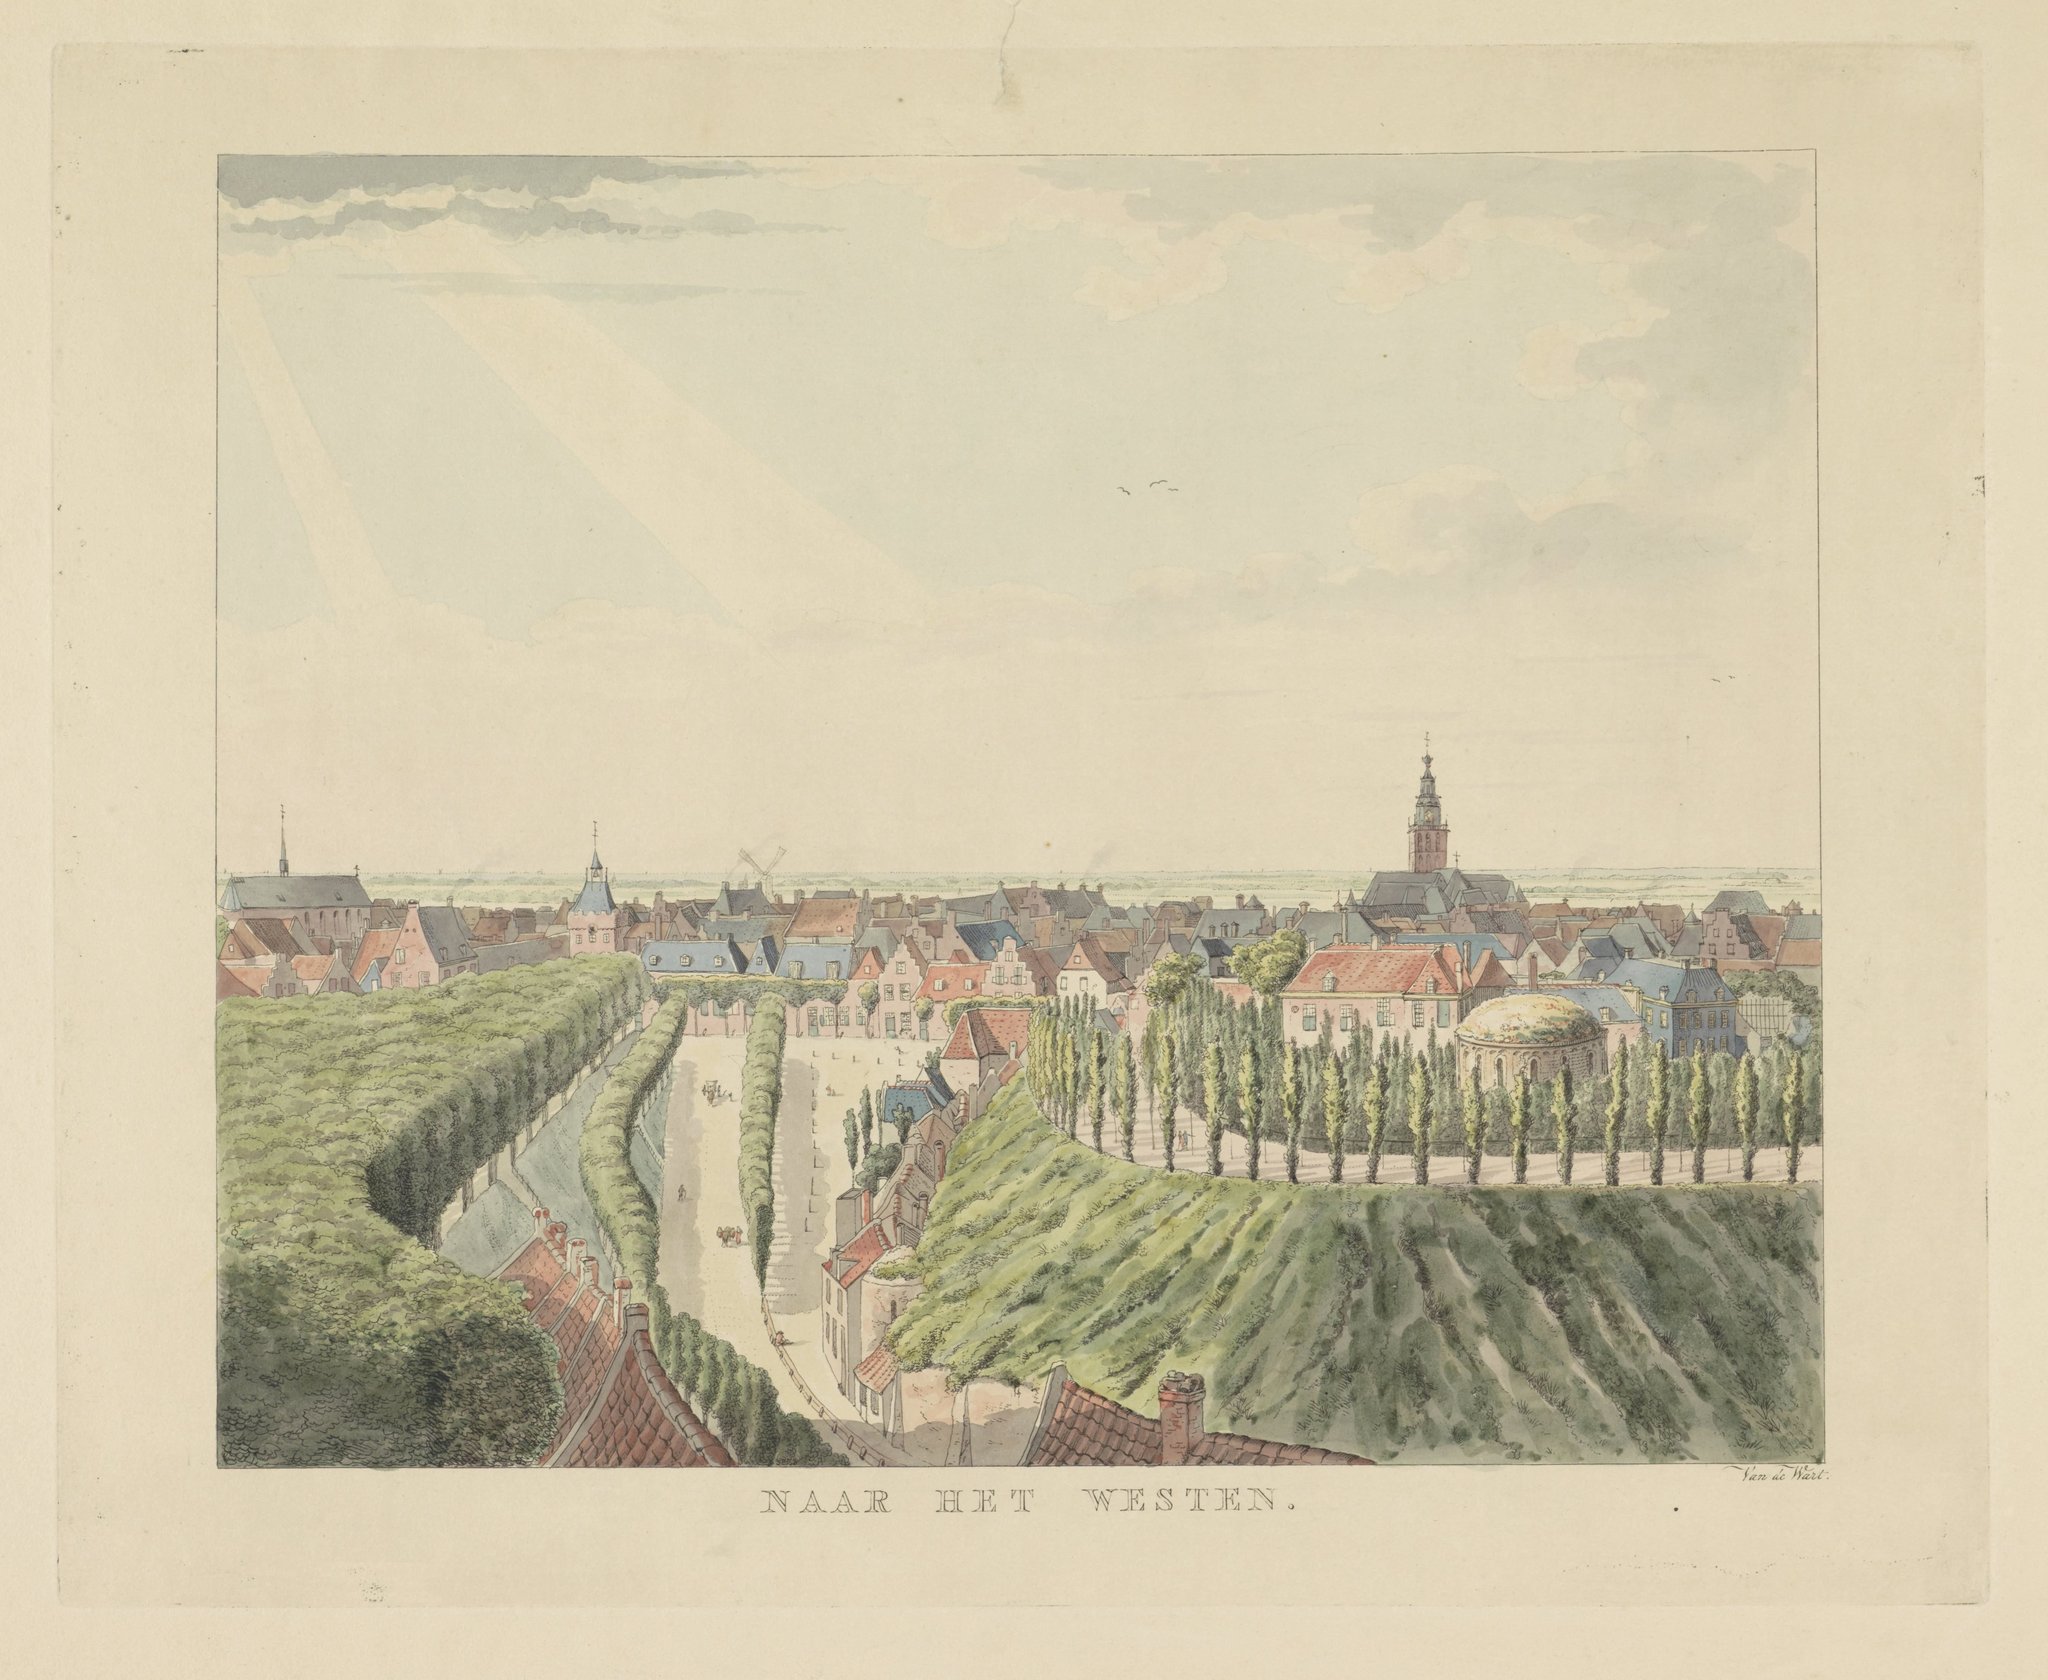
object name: print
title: Geldersch panorama of rondgezicht naar het leven geteekend op belvedére te Nymegen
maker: derk anthony van de wart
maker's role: draughtsman, painter, print maker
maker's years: 1767-1824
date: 1815-1824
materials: paper, watercolor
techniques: brush, etching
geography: nijmegen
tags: landscapes in the temperate zone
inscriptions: collector's mark: Lugt 2228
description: Nijmegen, zicht vanuit de Belvédère richting het westen. Weergegeven zijn de Stevenskerk, de Gasthuiskerk, het Valkhof met de Barbarossa-ruïne, de Burchtpoort en het Kelfkensbos. De prent is een onderdeel van een suite van negen prenten, inclusief de titelprent.